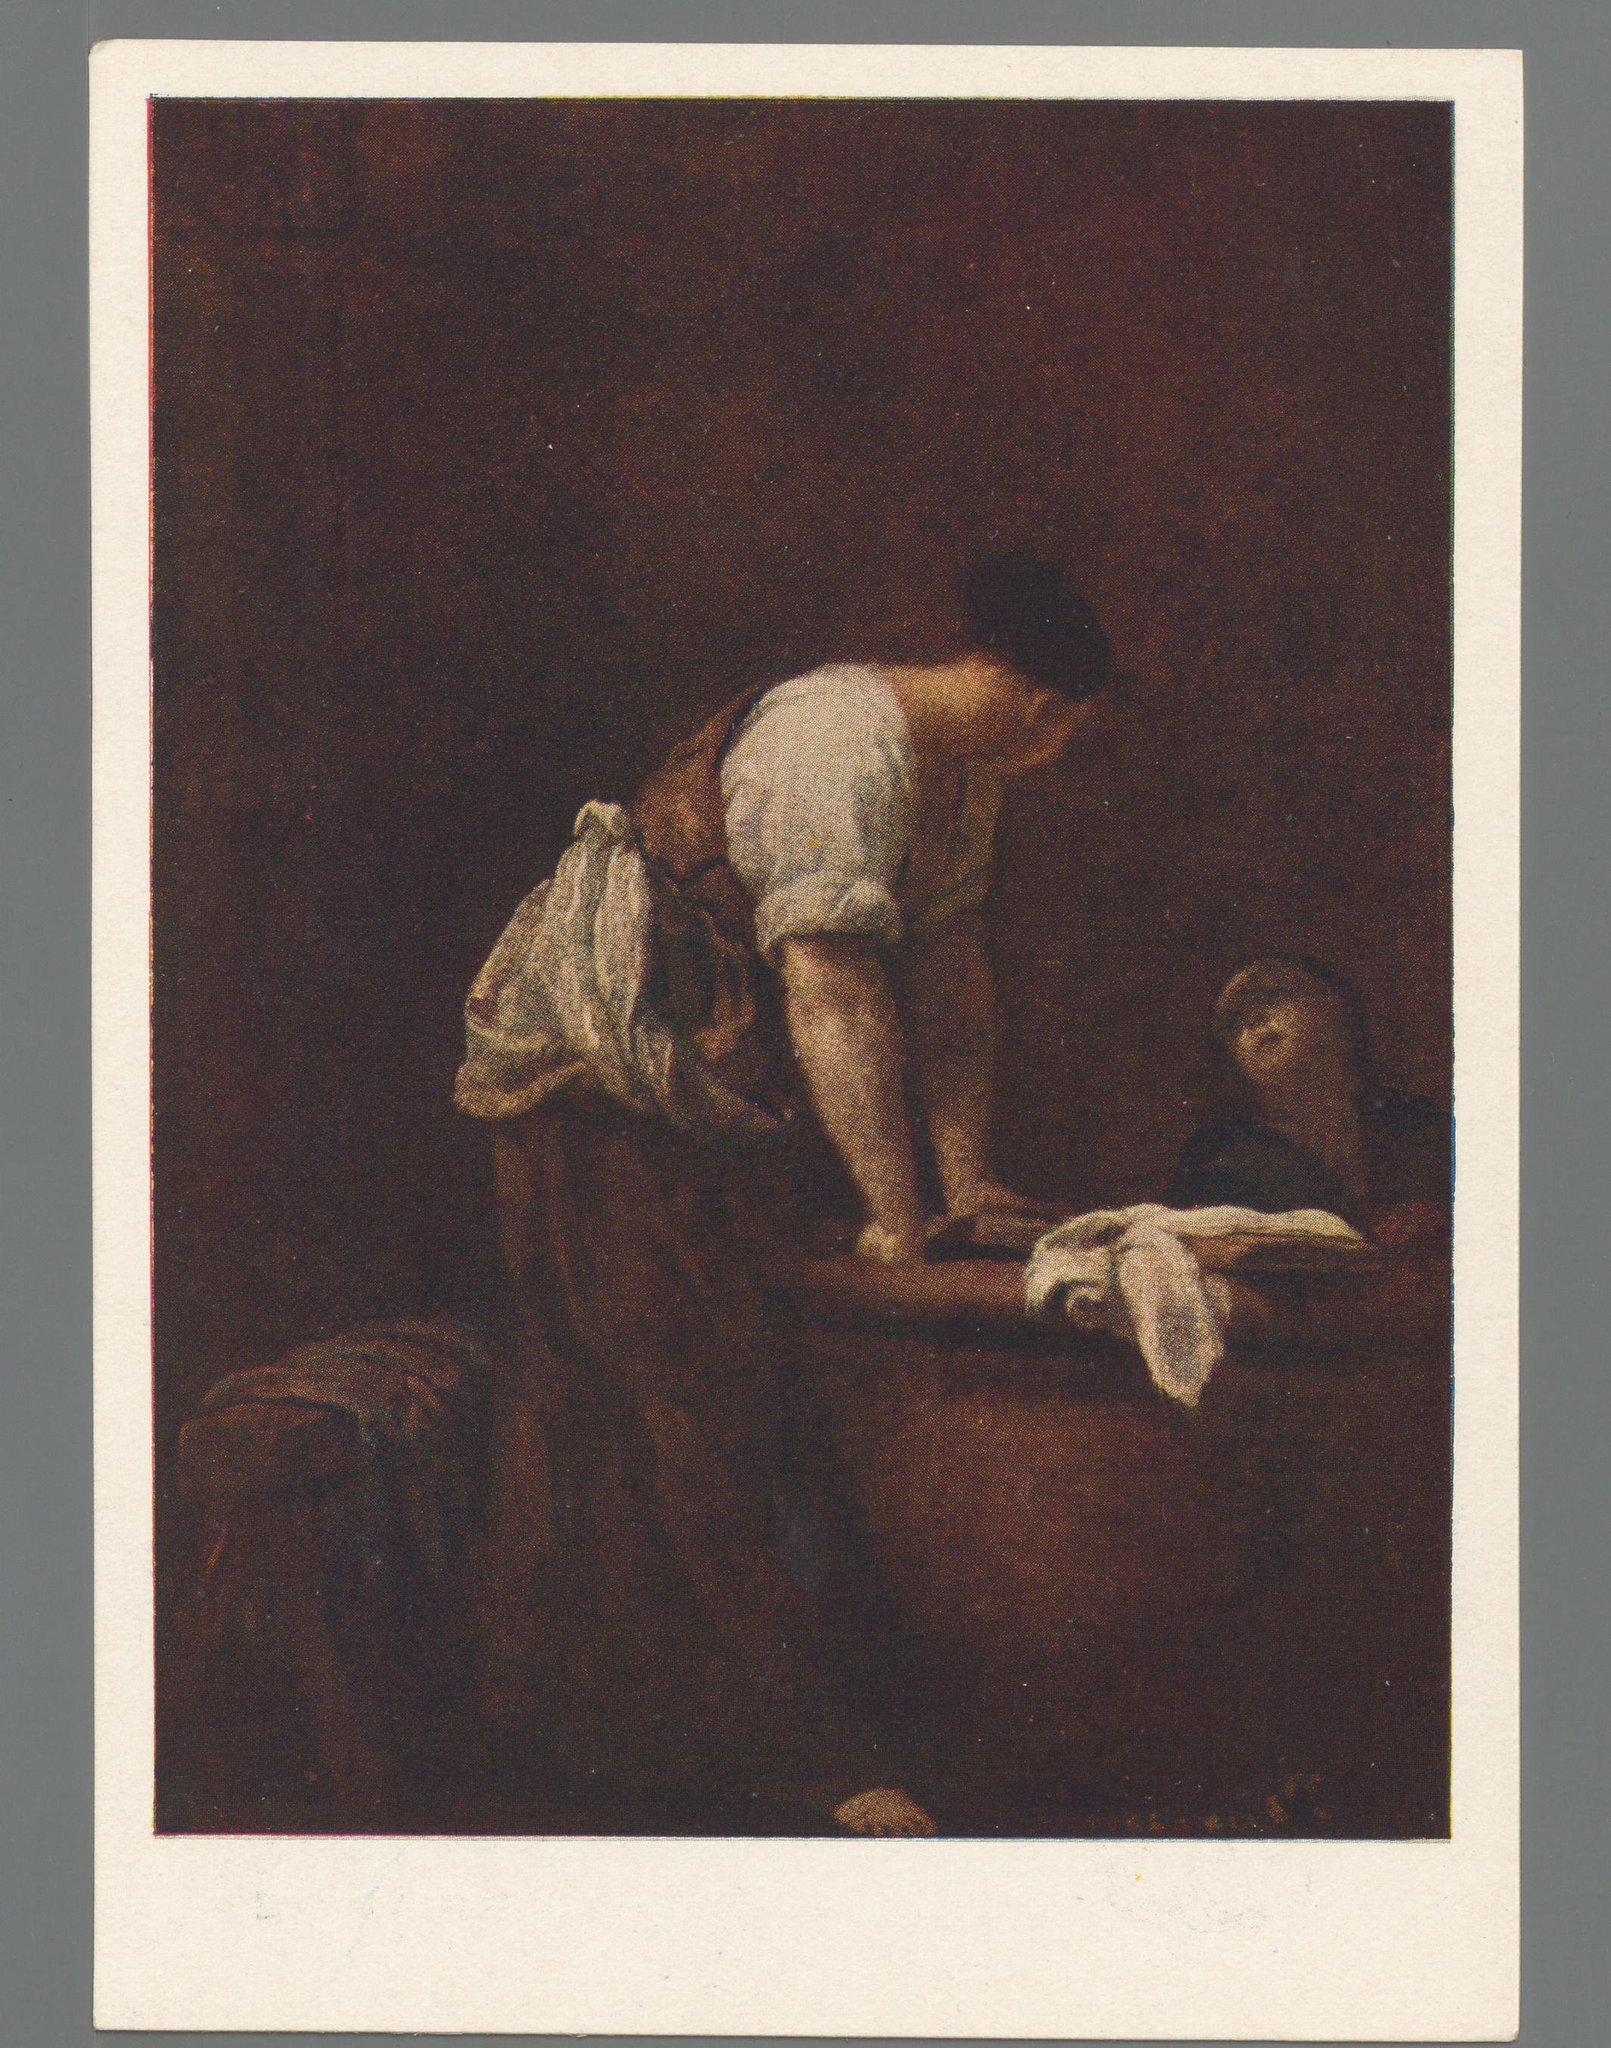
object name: ansichtkaart, prentbriefkaart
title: Giuseppe Marie Crespi. La Laveuse / Guiseppe-Maria Crespi. Laundress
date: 1956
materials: cardboard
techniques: color autotype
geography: leningrad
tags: permanent exhibition, museum, picture, painting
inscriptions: date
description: De titel op object staat ook in het Russisch.